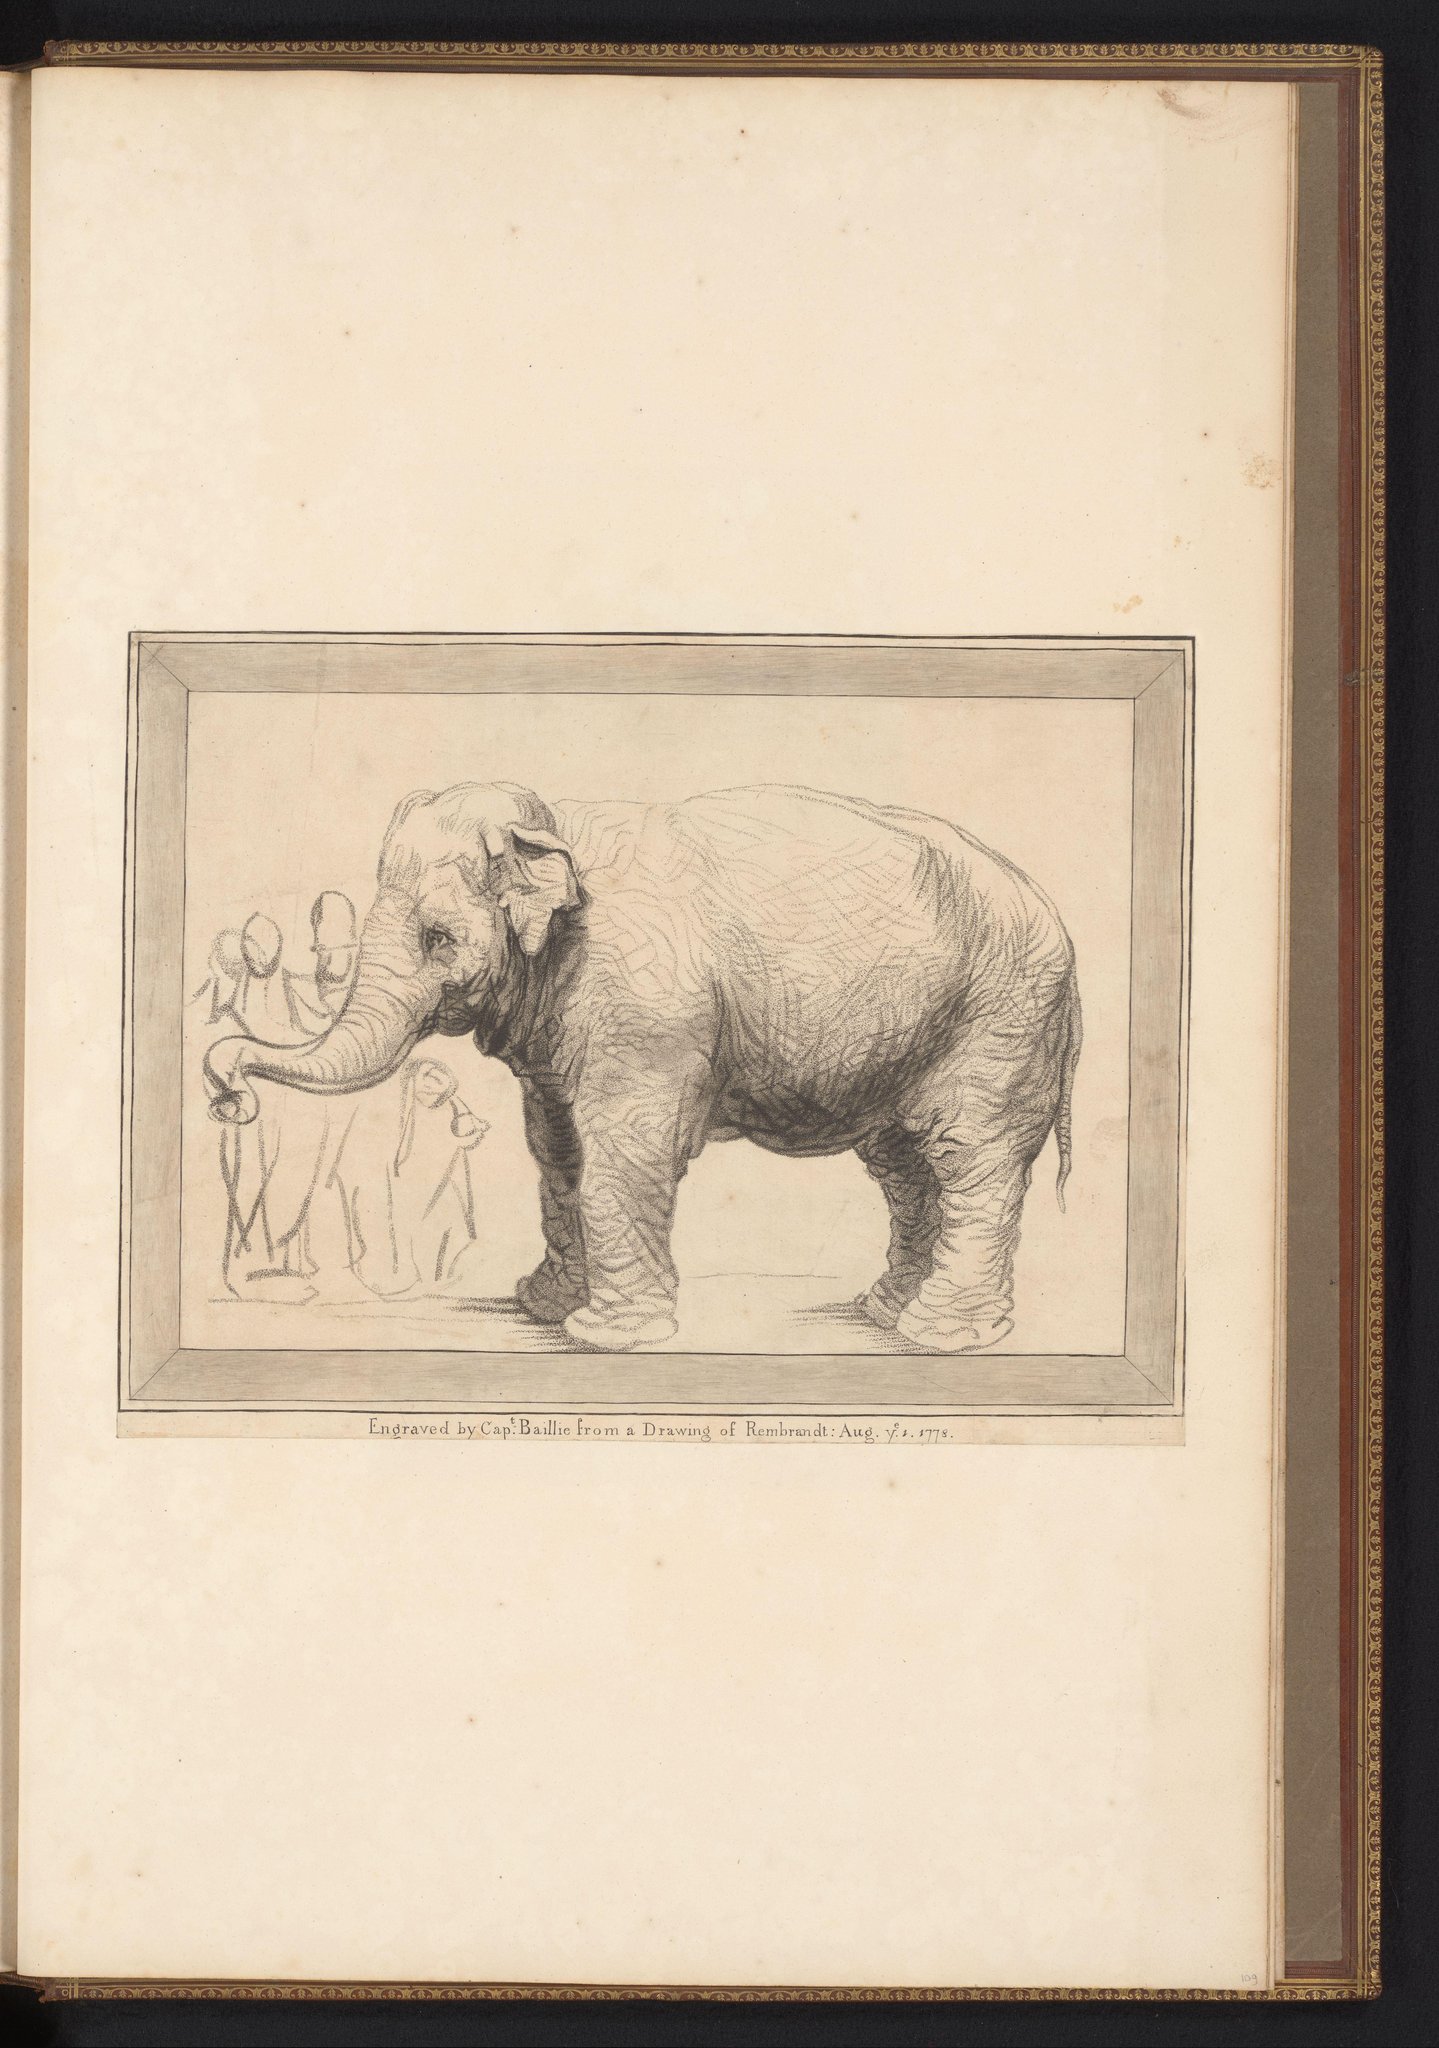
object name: print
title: Olifant met omstanders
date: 1778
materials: paper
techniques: printmaking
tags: trunked animals: elephant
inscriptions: date